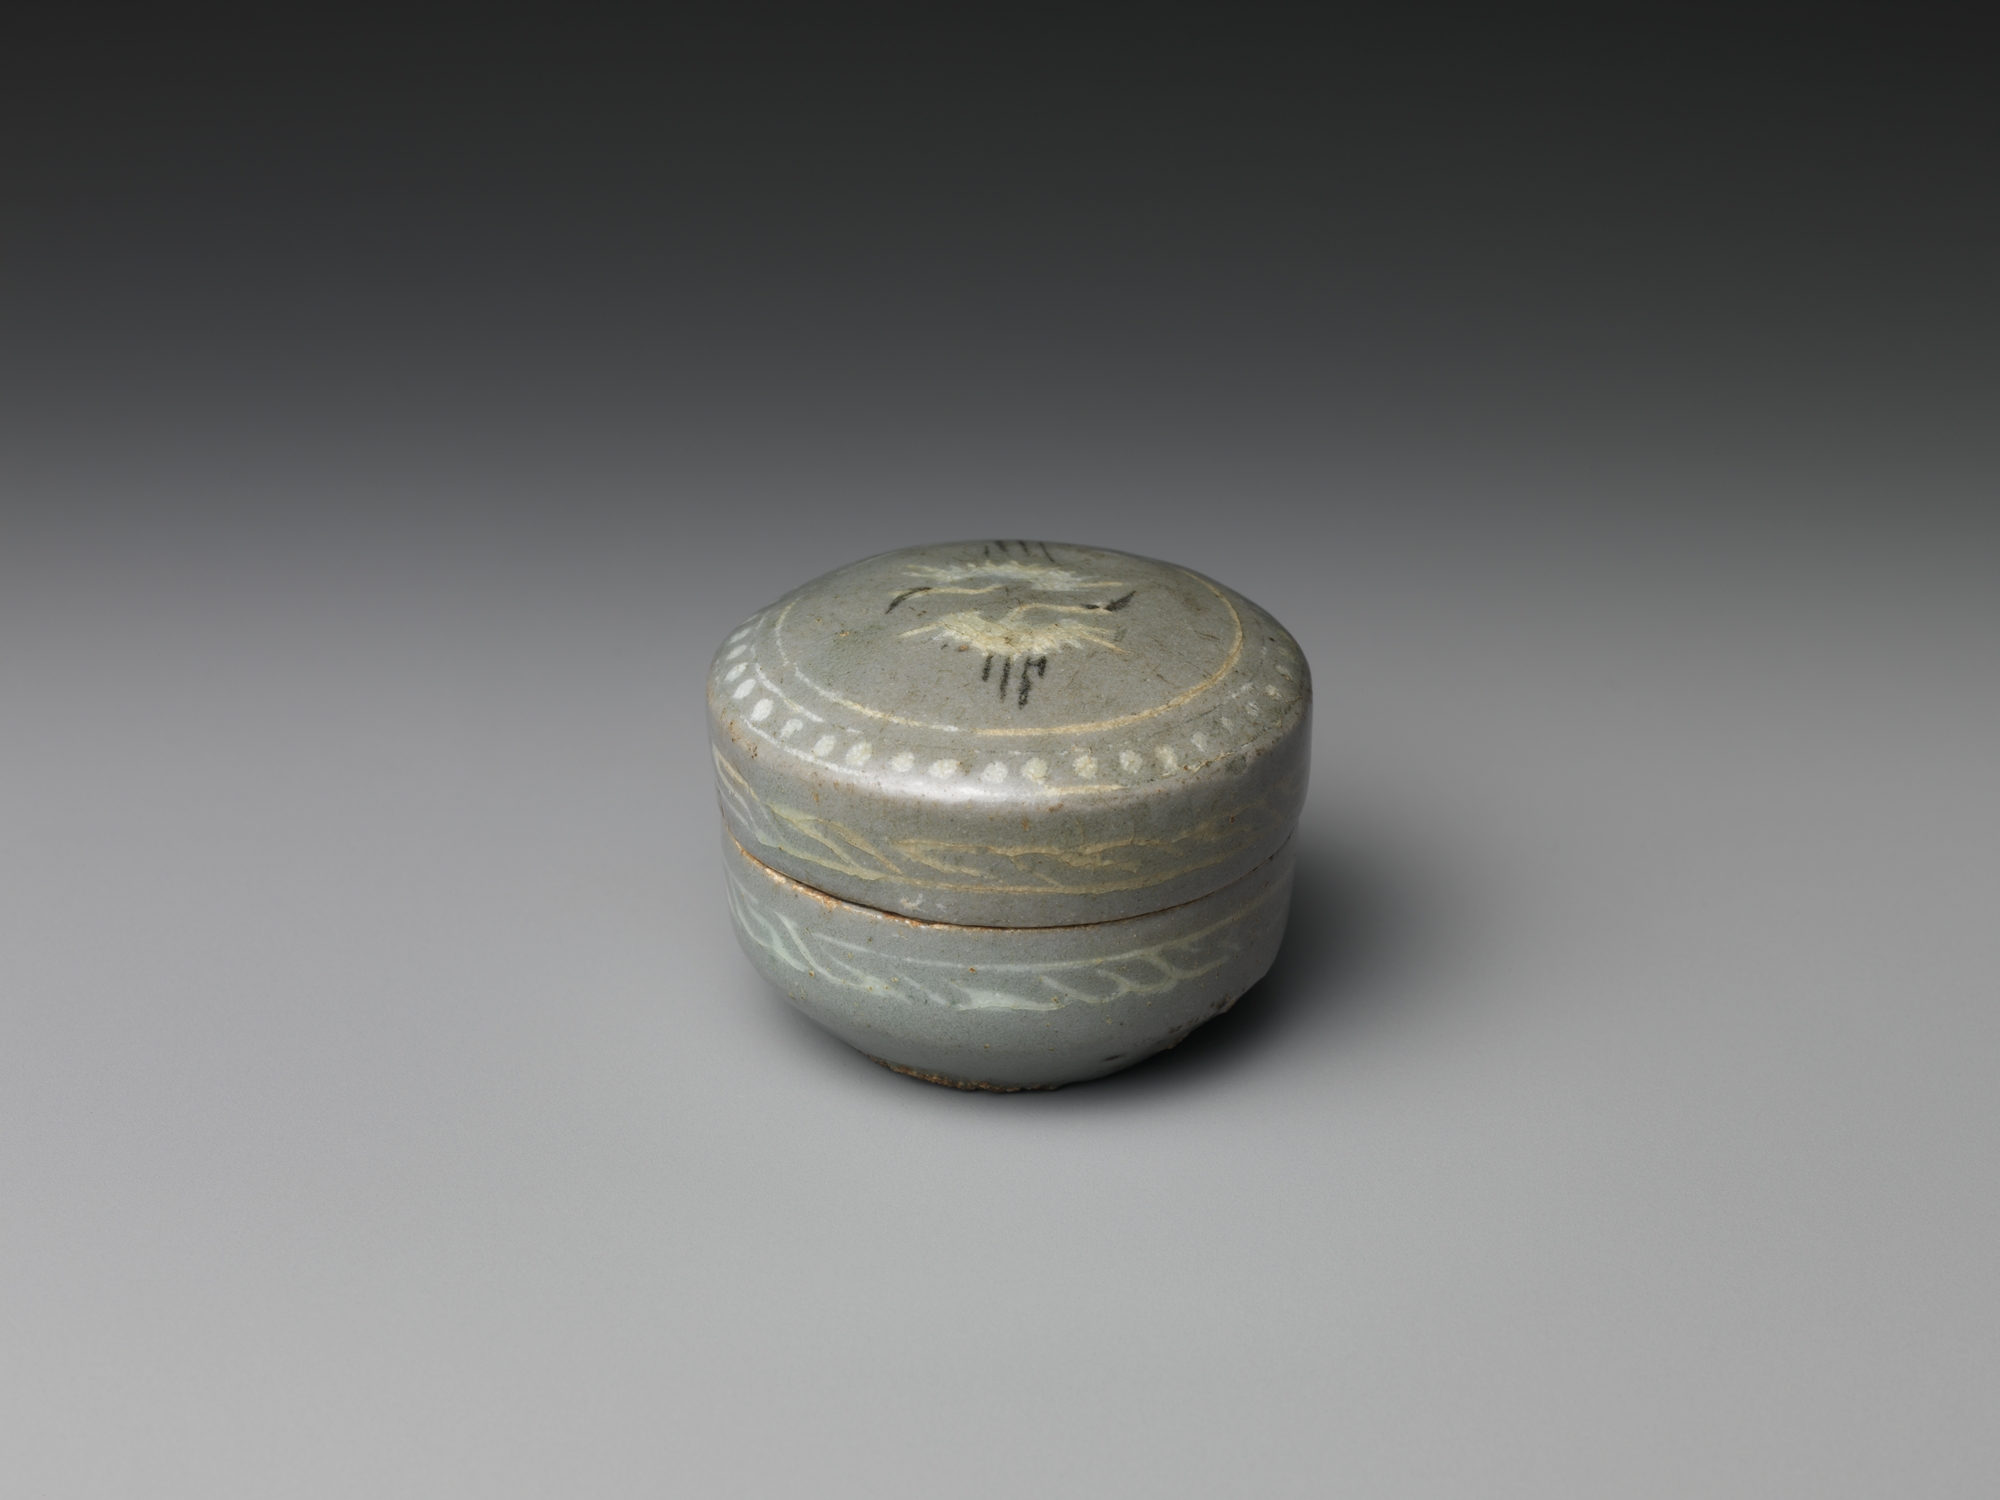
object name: box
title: Box from set of five decorated with cranes and clouds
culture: korean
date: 1201-1400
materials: ceramic glaze, glaze, stoneware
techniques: inlay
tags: cranes